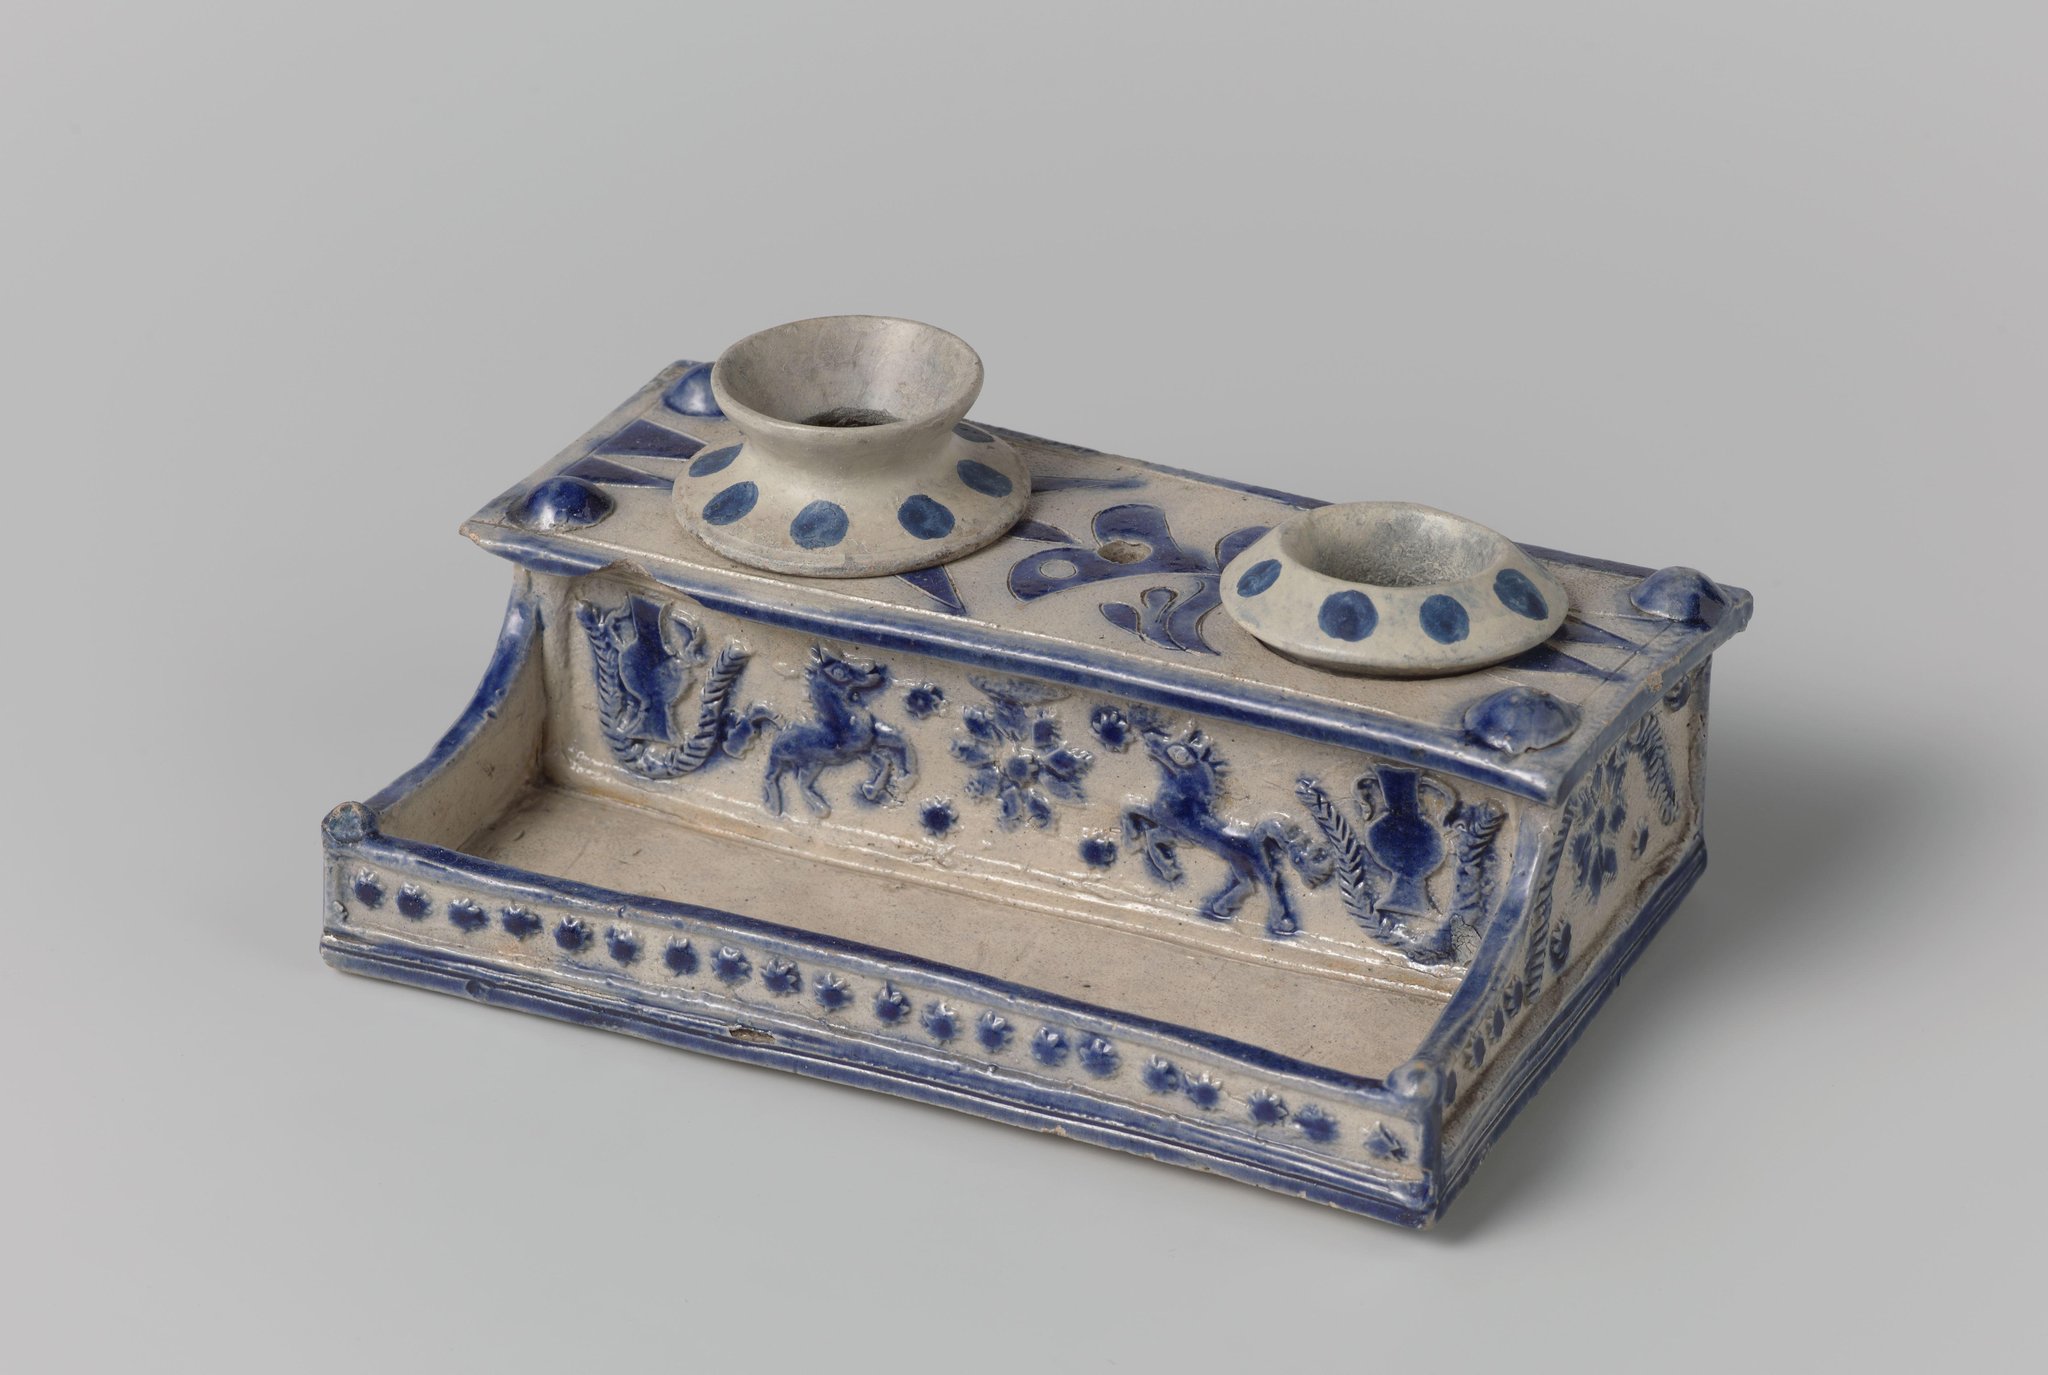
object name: inkwell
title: Ink well with blue dots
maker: Anonymous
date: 1750-1799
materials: glaze, paint, stoneware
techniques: firing, forming, turning, vitrification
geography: westerwald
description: Inktpot van steengoed met een cilindervormig lichaam en uitstekende rand met opstaande hals om in de houder te hangen. Beschilderd met blauwe stippen. Westerwald.